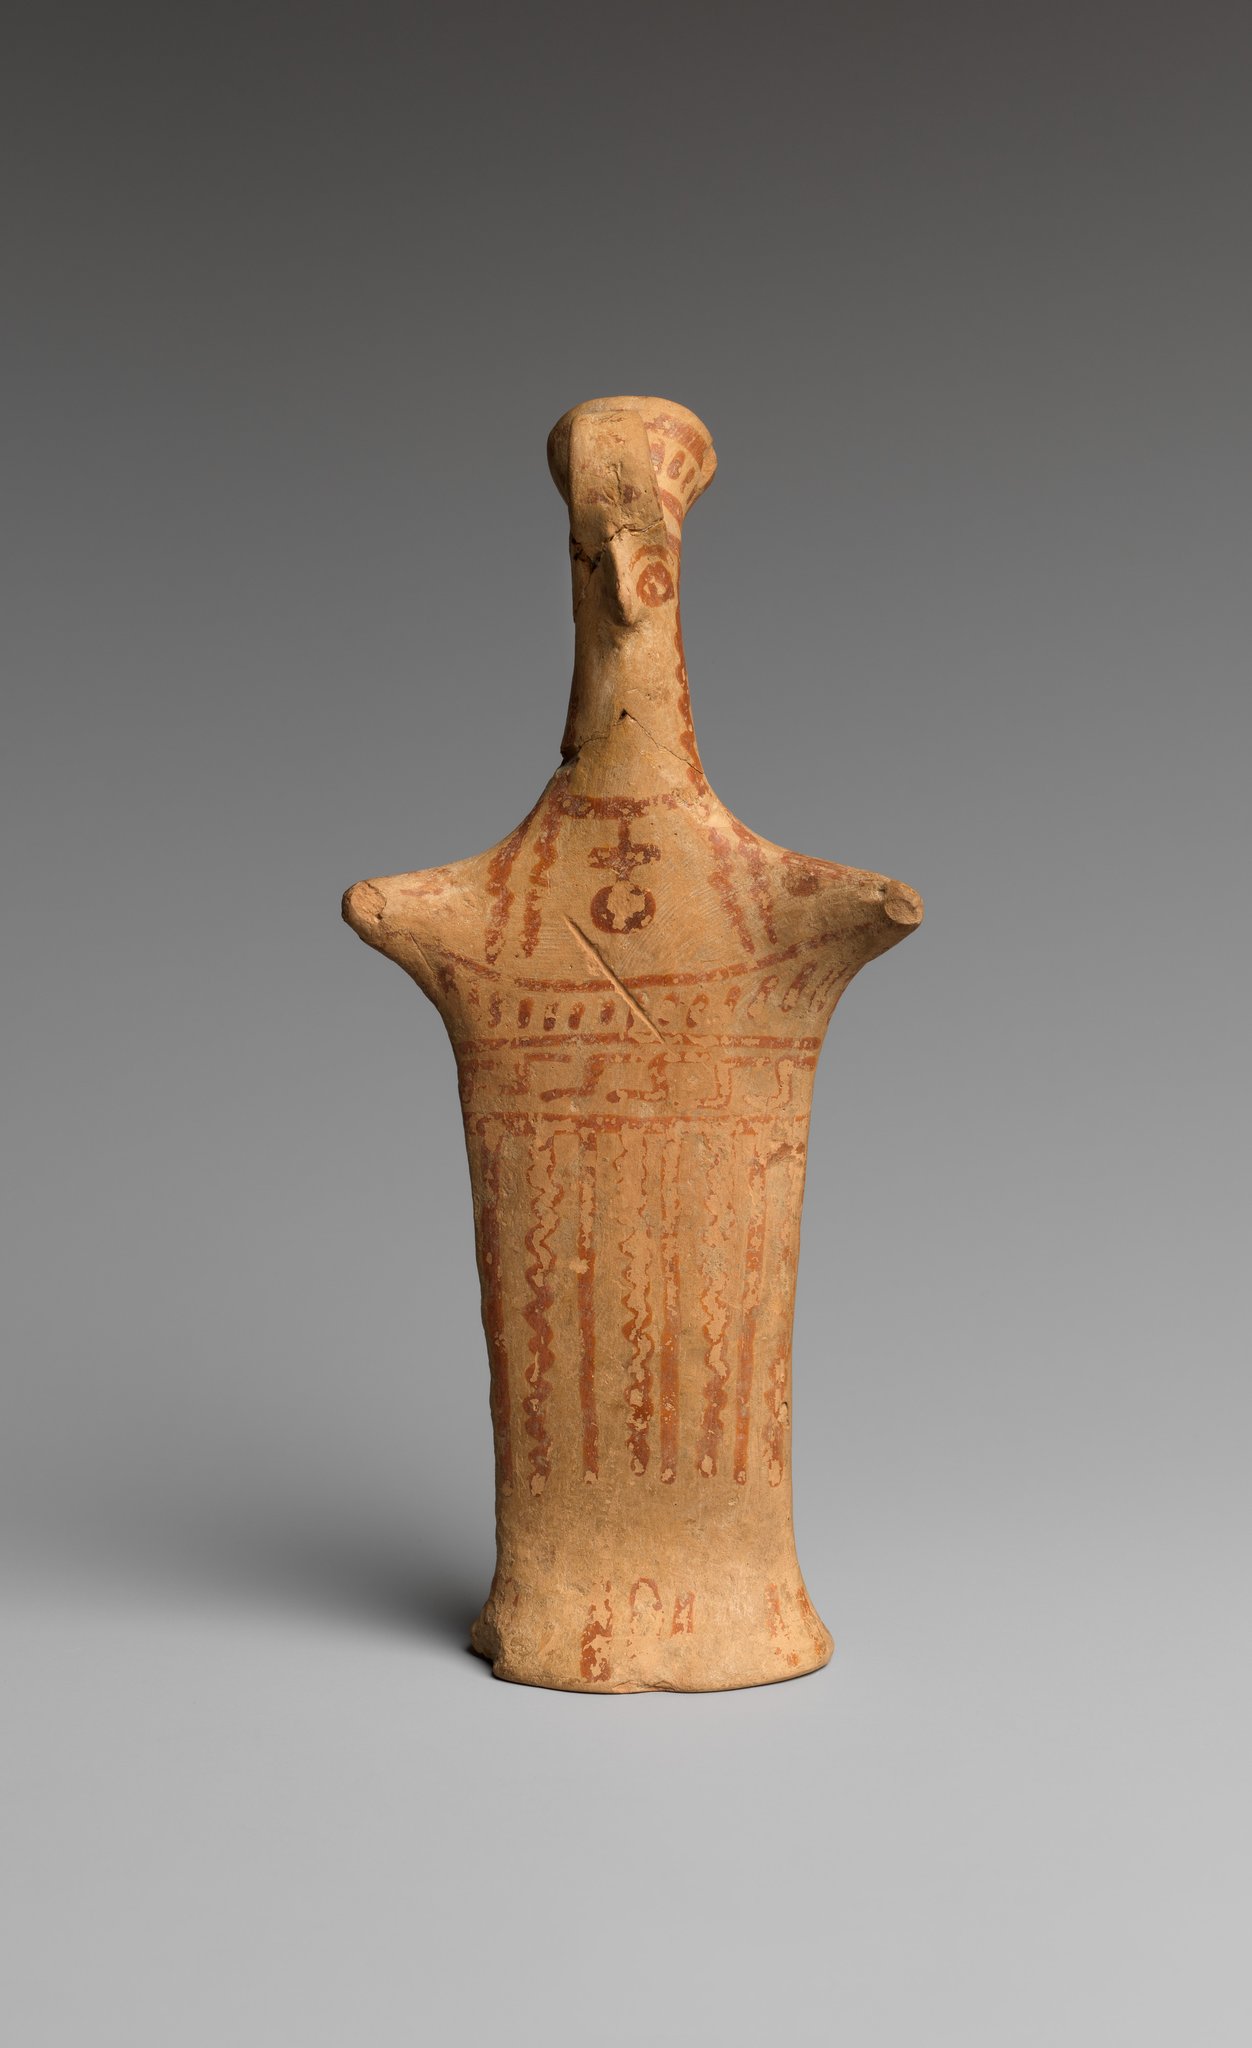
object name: female figure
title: Terracotta statuette of a goddess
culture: boeotian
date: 567-535 BCE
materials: terracotta